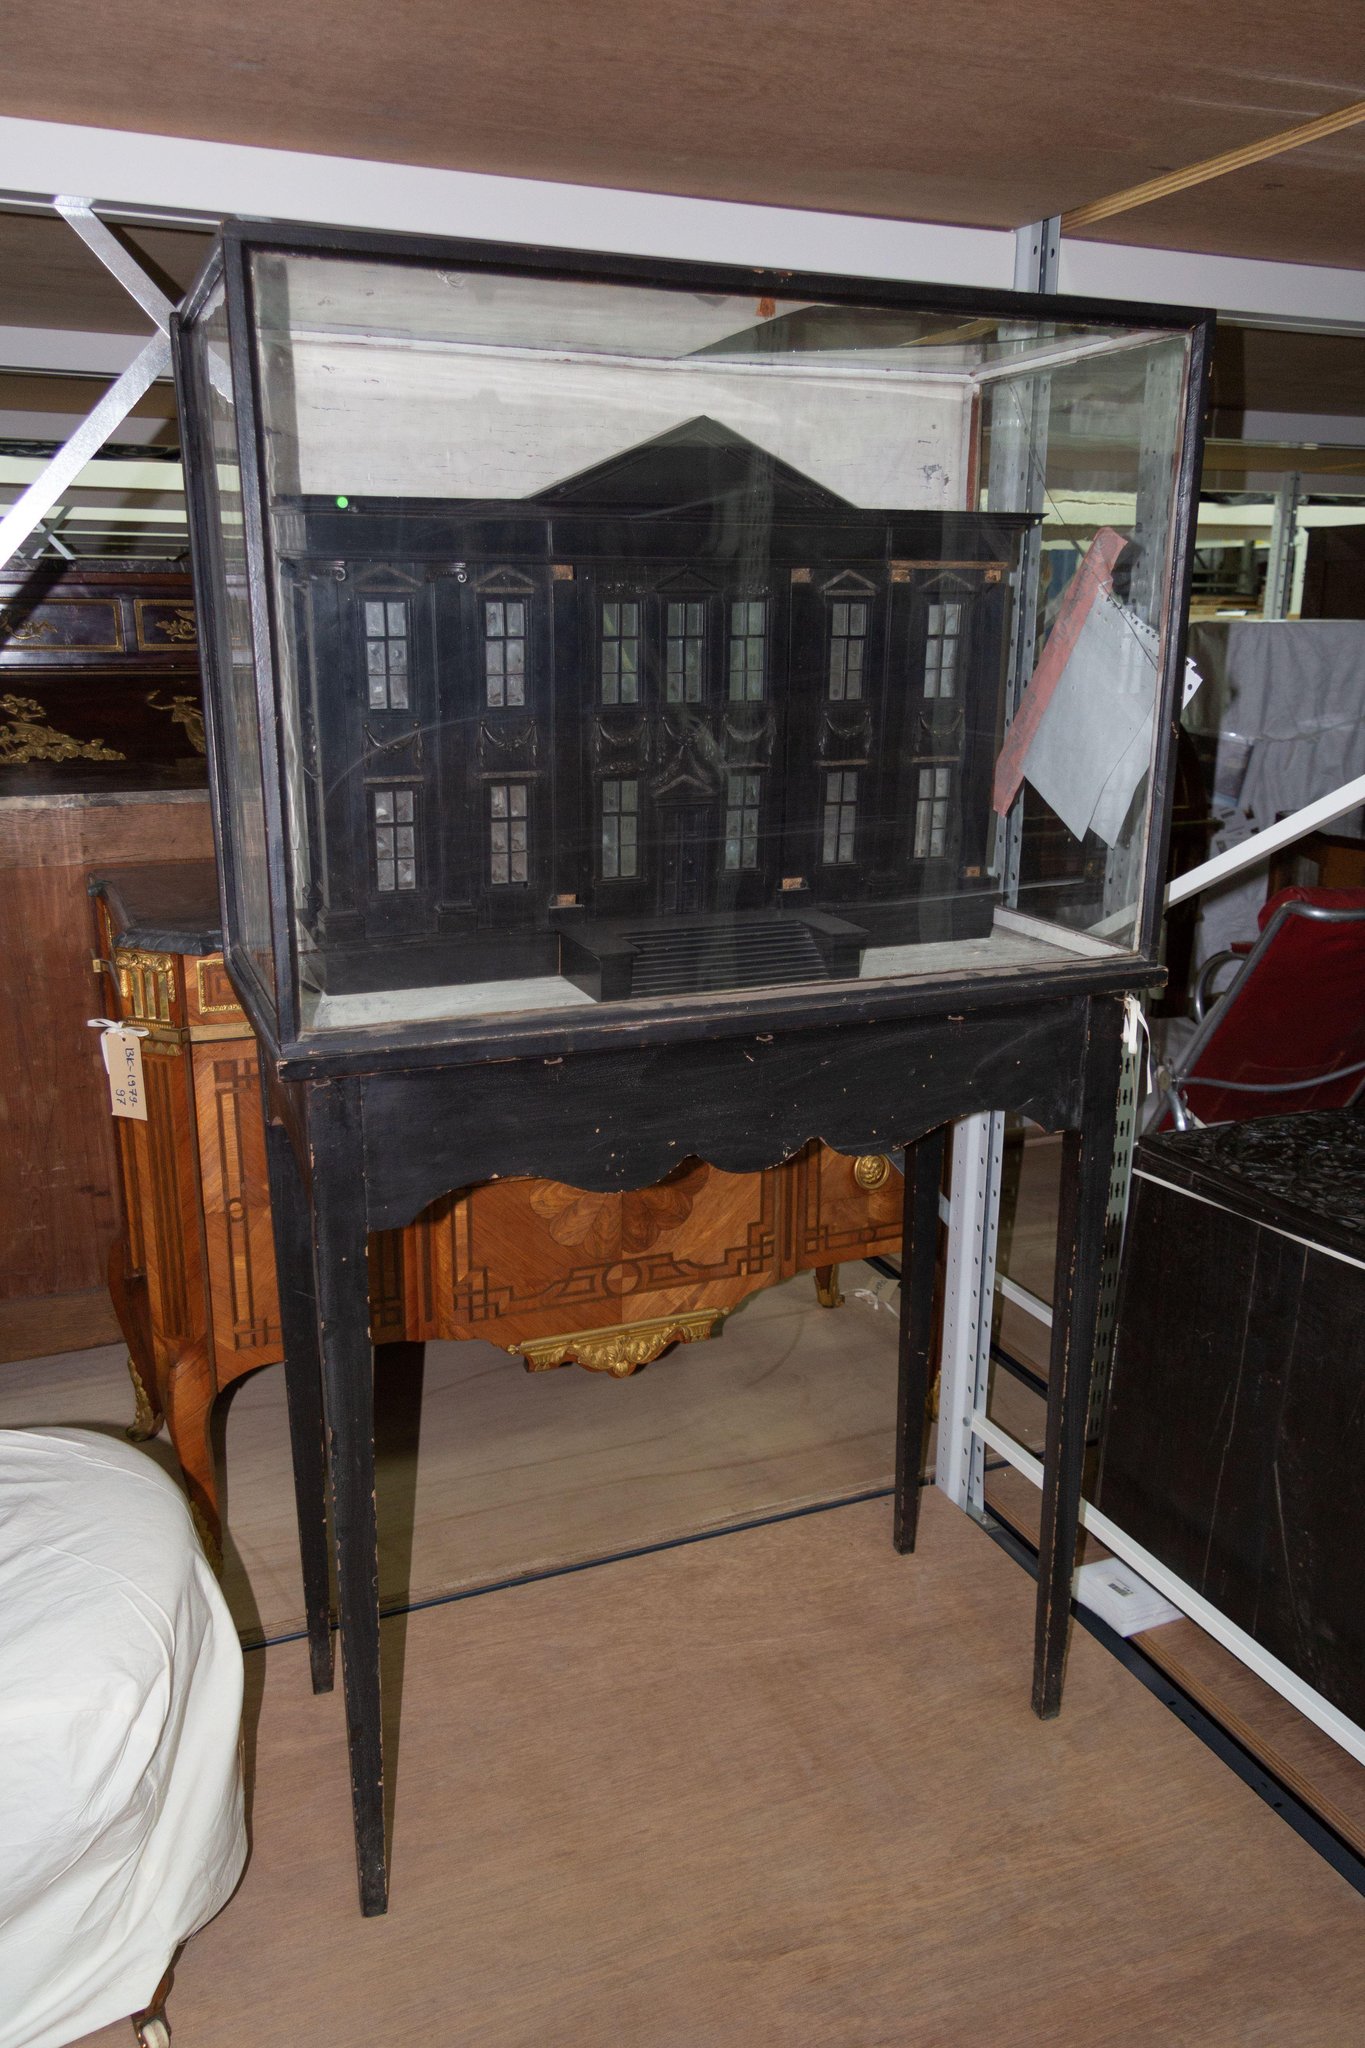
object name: furniture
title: Medaillekast in de vorm van Mauritshuis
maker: Anonymous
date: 1800-1900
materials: wood, glass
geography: netherlands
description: Medaillekast van ebbenhout met spiegelglas in de vorm van de voorgevel van het Mauritshuis te 's Gravenhage, geplaatst op een voet en onder een stolp.